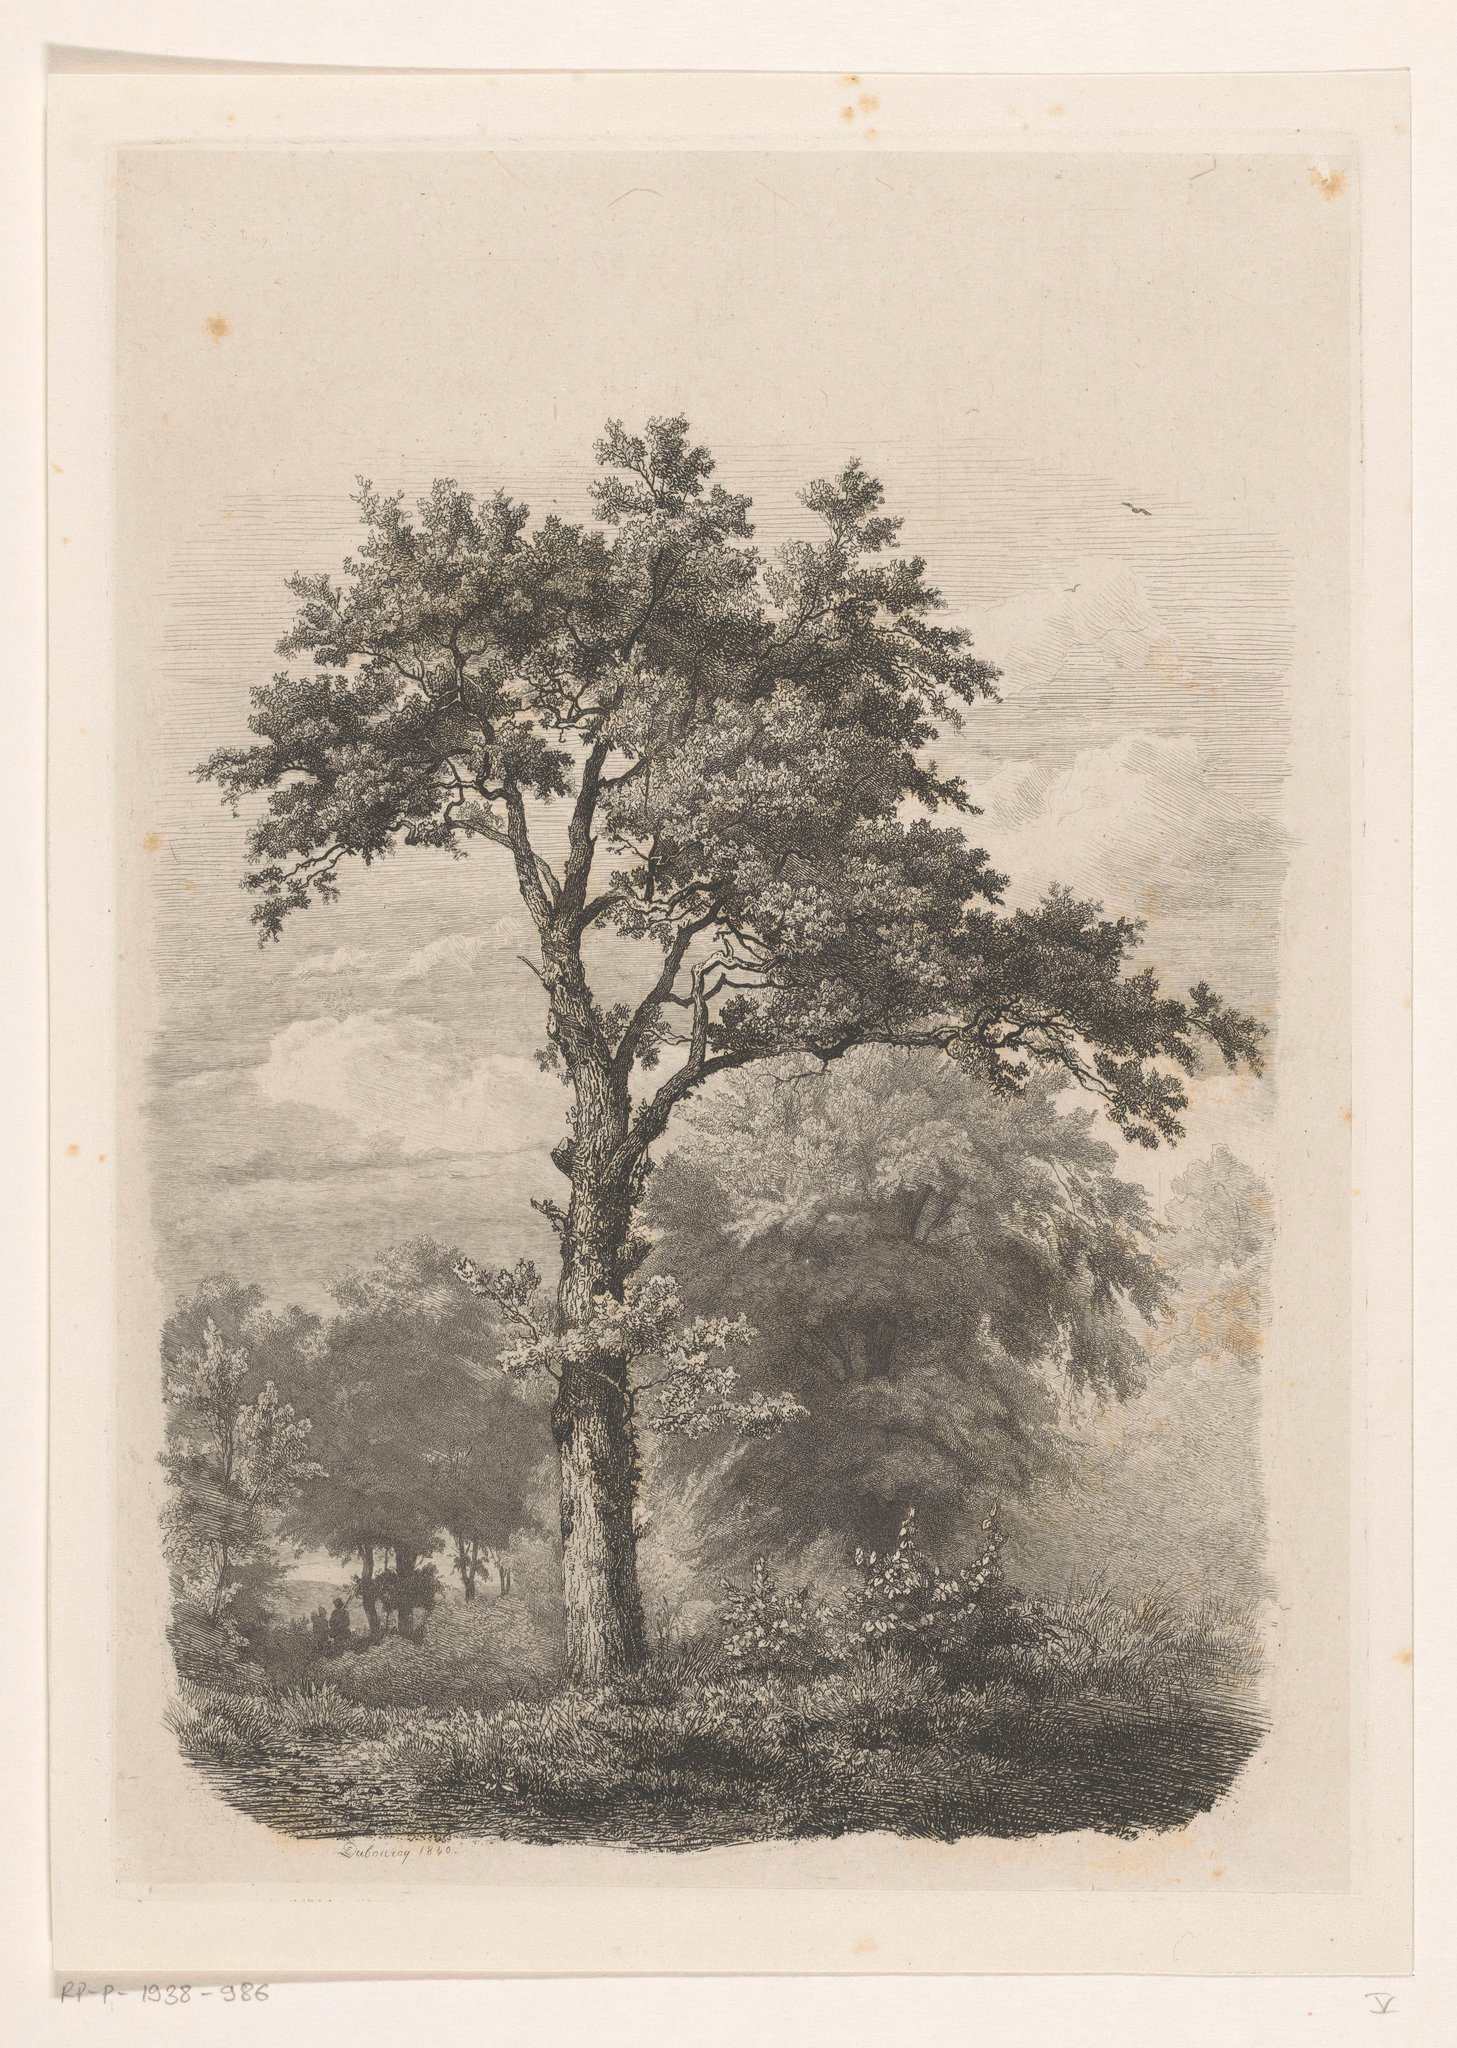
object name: print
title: Vijf etsproeven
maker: pierre louis dubourcq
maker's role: draughtsman, painter, print maker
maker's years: 1815-1873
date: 1840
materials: paper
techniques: drypoint, etching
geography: netherlands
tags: trees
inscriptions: collector's mark: Lugt 2228, collector's mark: Lugt 2760